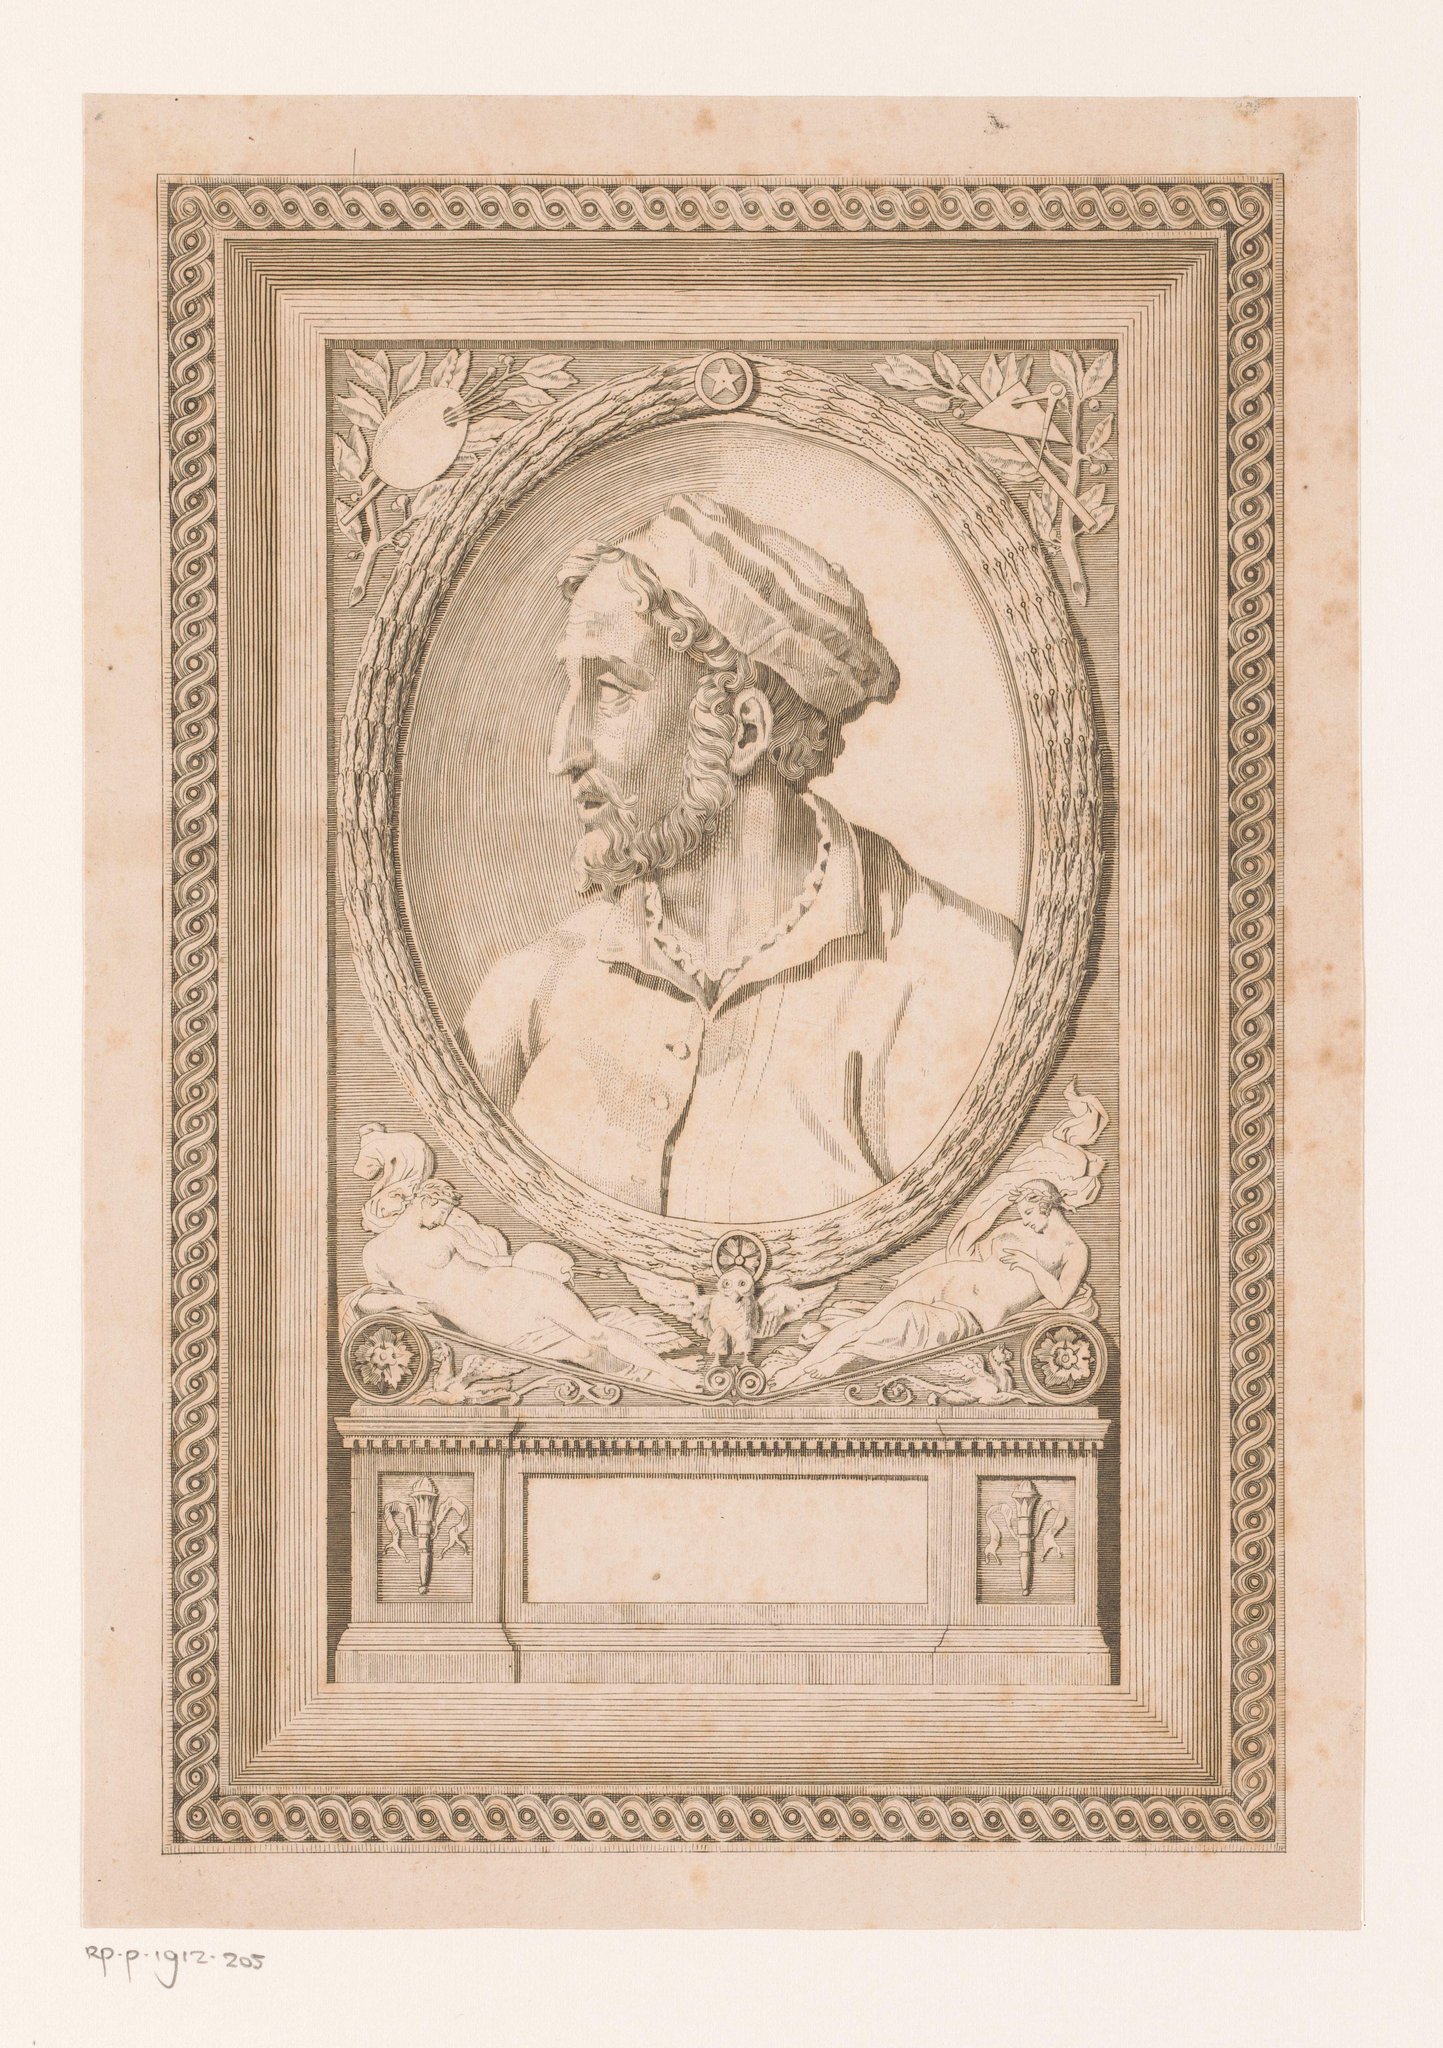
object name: print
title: Portret van Michelangelo in een decoratieve rand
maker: jean théodore joseph linnig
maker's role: draughtsman, print maker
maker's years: 1815-1891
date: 1825-1891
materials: paper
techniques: etching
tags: rome, painter, draughtsman, michelangelo, portrait, self-portrait of painter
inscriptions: collector's mark: Lugt 2228